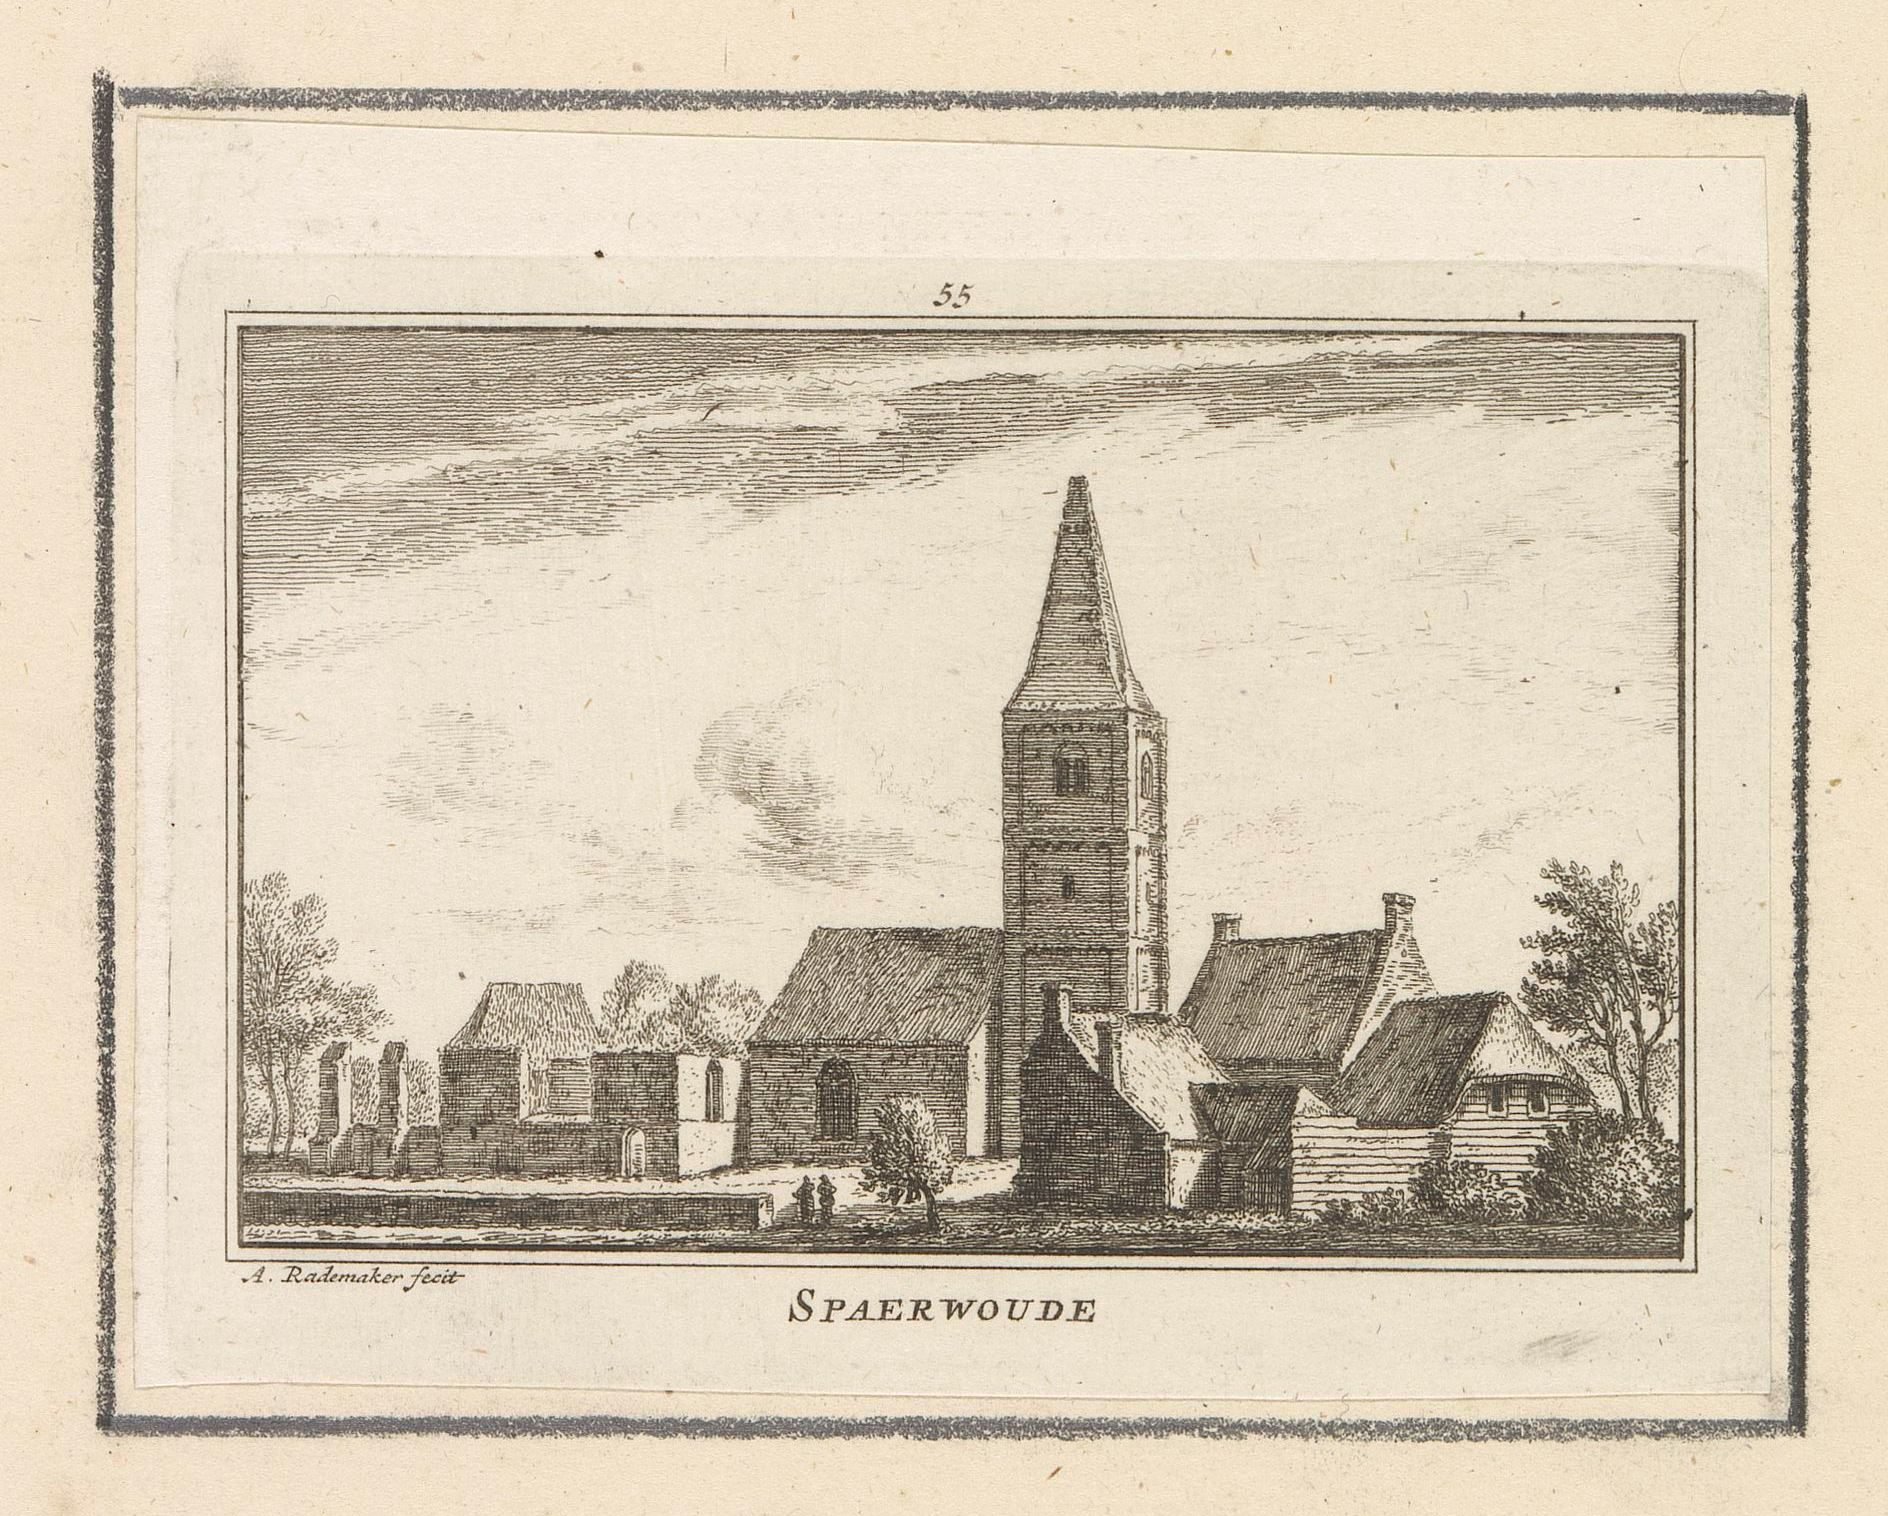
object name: print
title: Spaerwoude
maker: abraham rademaker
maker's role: draughtsman, print maker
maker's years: 1676-1735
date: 1725-1803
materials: paper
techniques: engraving, etching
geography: amsterdam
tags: prospect of village, silhouette of village, church (exterior)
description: Prent ook gebruikt in: Rademaker, Abraham. Kabinet van Nederlandsche outheden en gezichten: vervat in 300 konstplaaten (…). 2 delen. Amsterdam: Willem Barents, 1725, dl. 1, ill. 55. Na 1725 is deze prent nog in verschillende heruitgaven verschenen, uitgegeven in 1727-1733, 1770-1771 en 1792-1803. Uit welke uitgave het huidige exemplaar precies komt is niet na te gaan.